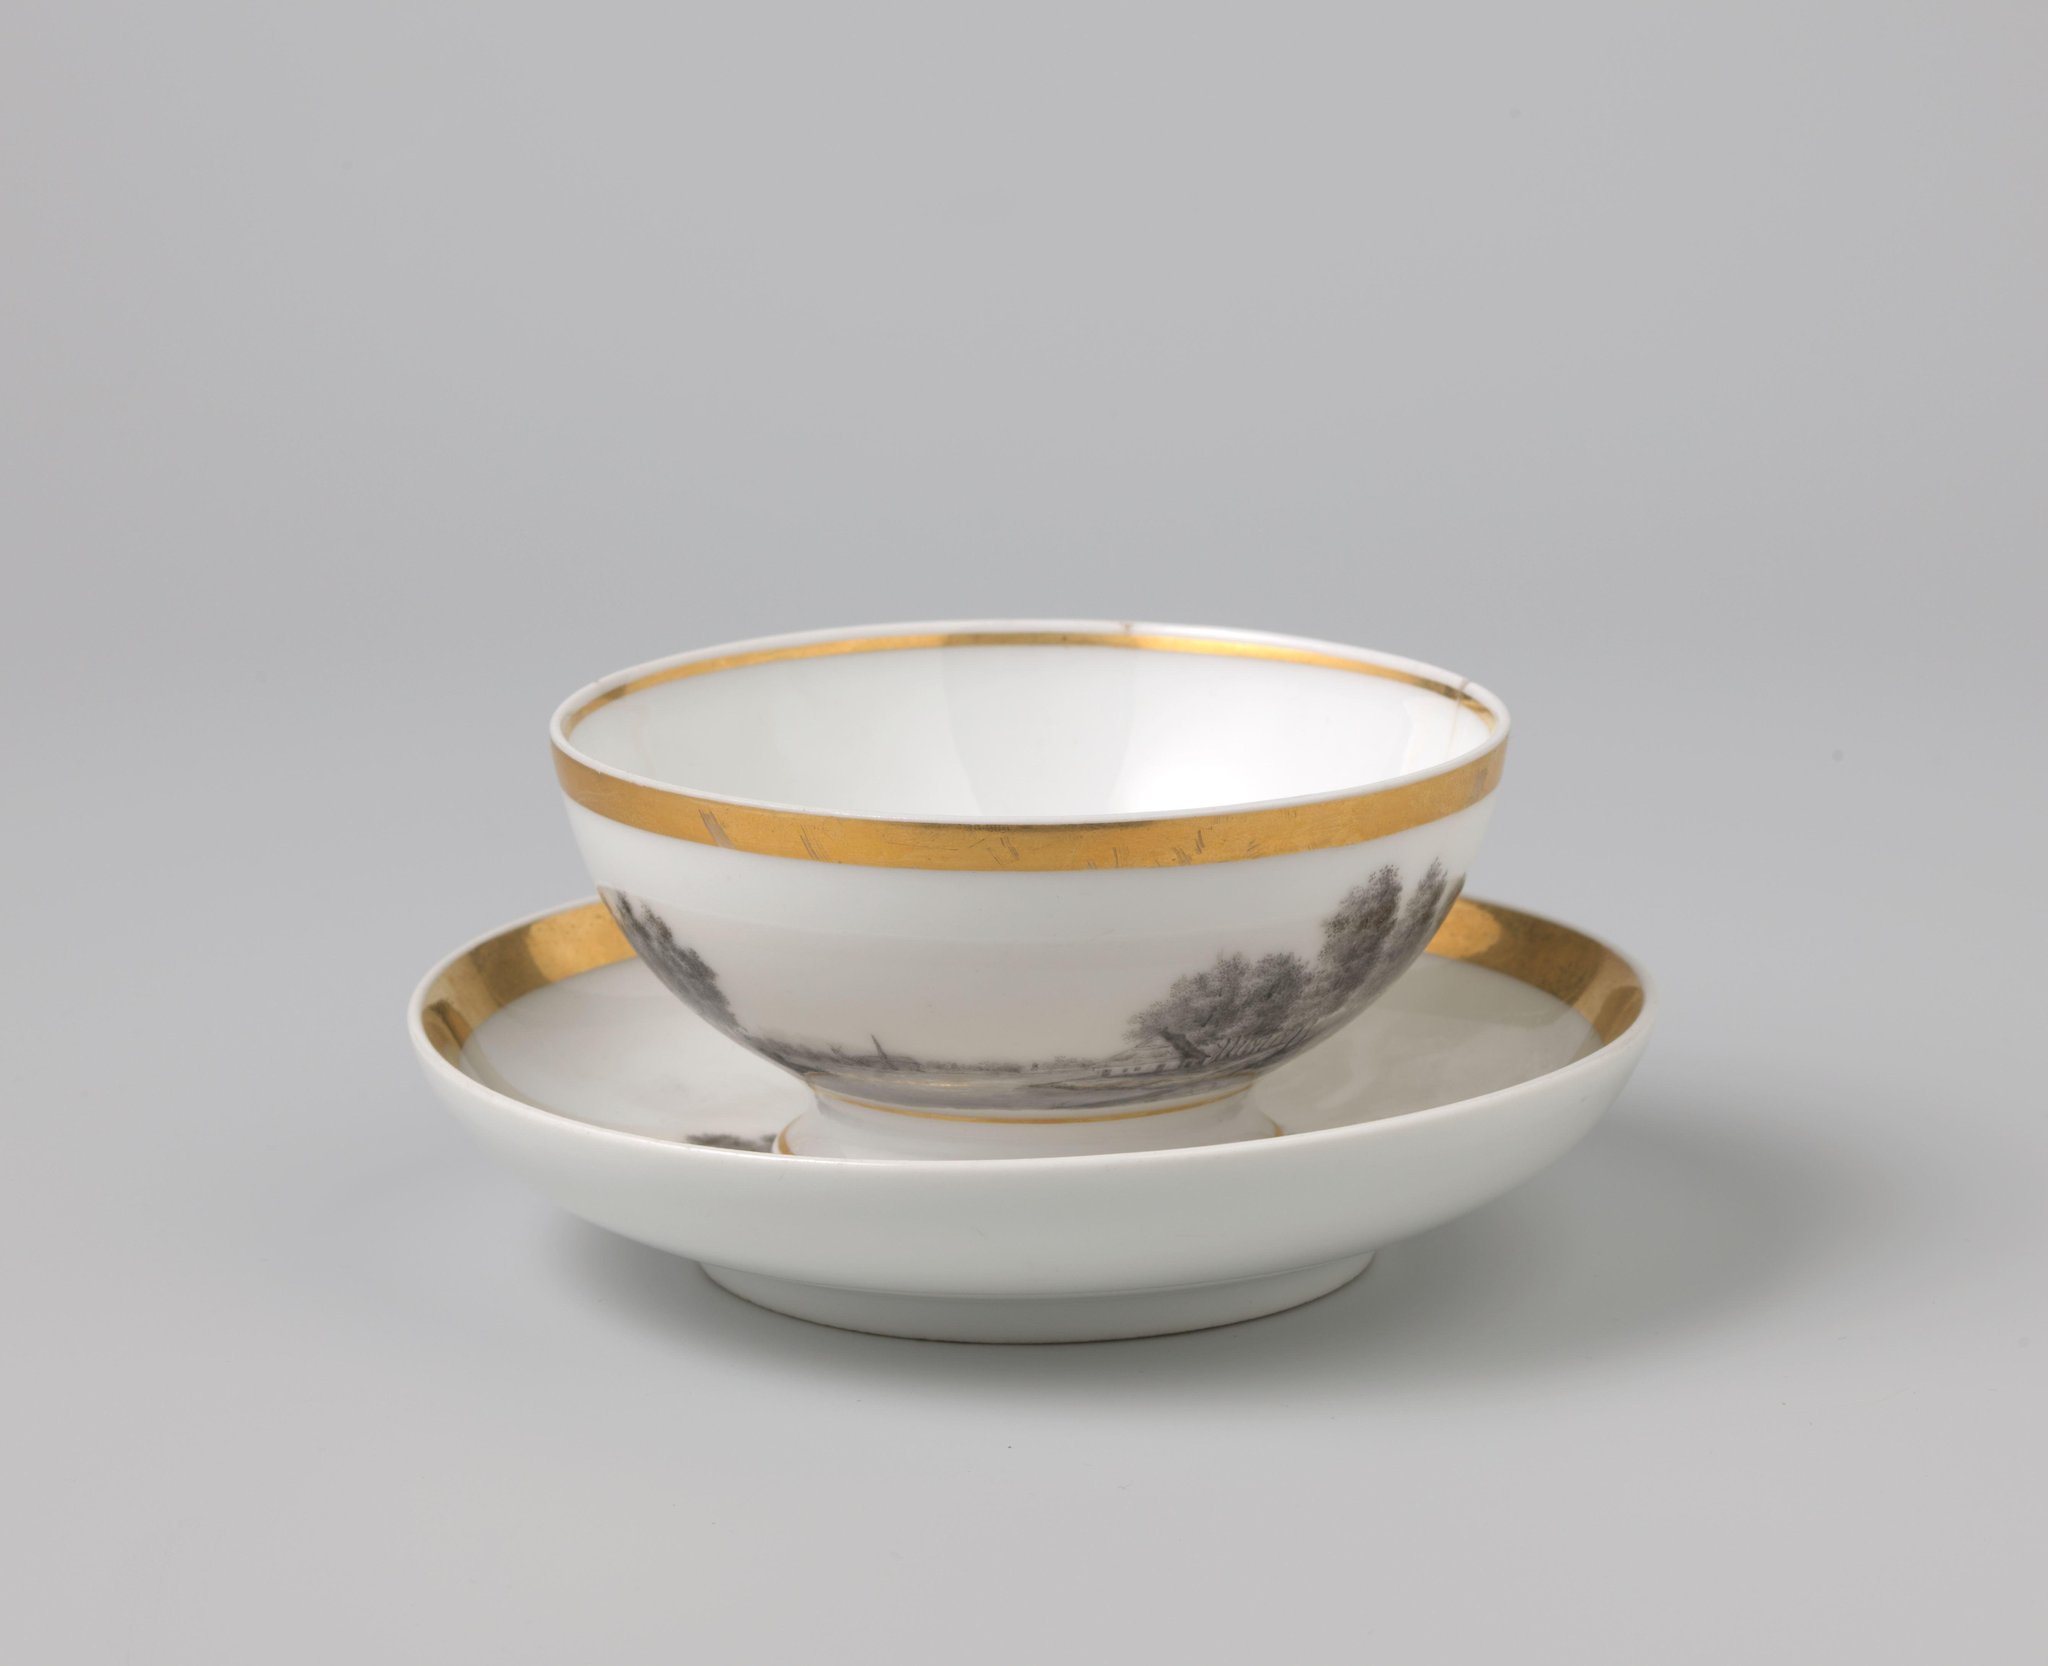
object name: cup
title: Cup with a water landscape and a monogram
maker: Anonymous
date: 1850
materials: glaze, gold, paint, porcelain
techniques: firing, forming, gilding, turning, vitrification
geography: europe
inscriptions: mark: ‘VD’, inscription: ‘I:D:H.’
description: Kom van porselein, beschilderd in encre-de-Chine met een rivierlandschap. Brede gouden bies langs mond- en voetrand. Op de achterkant van de kom I:D:H: in goud. Gemerkt met schildje waarin de letters VD in reliëf. Opmerking: barst in kom.